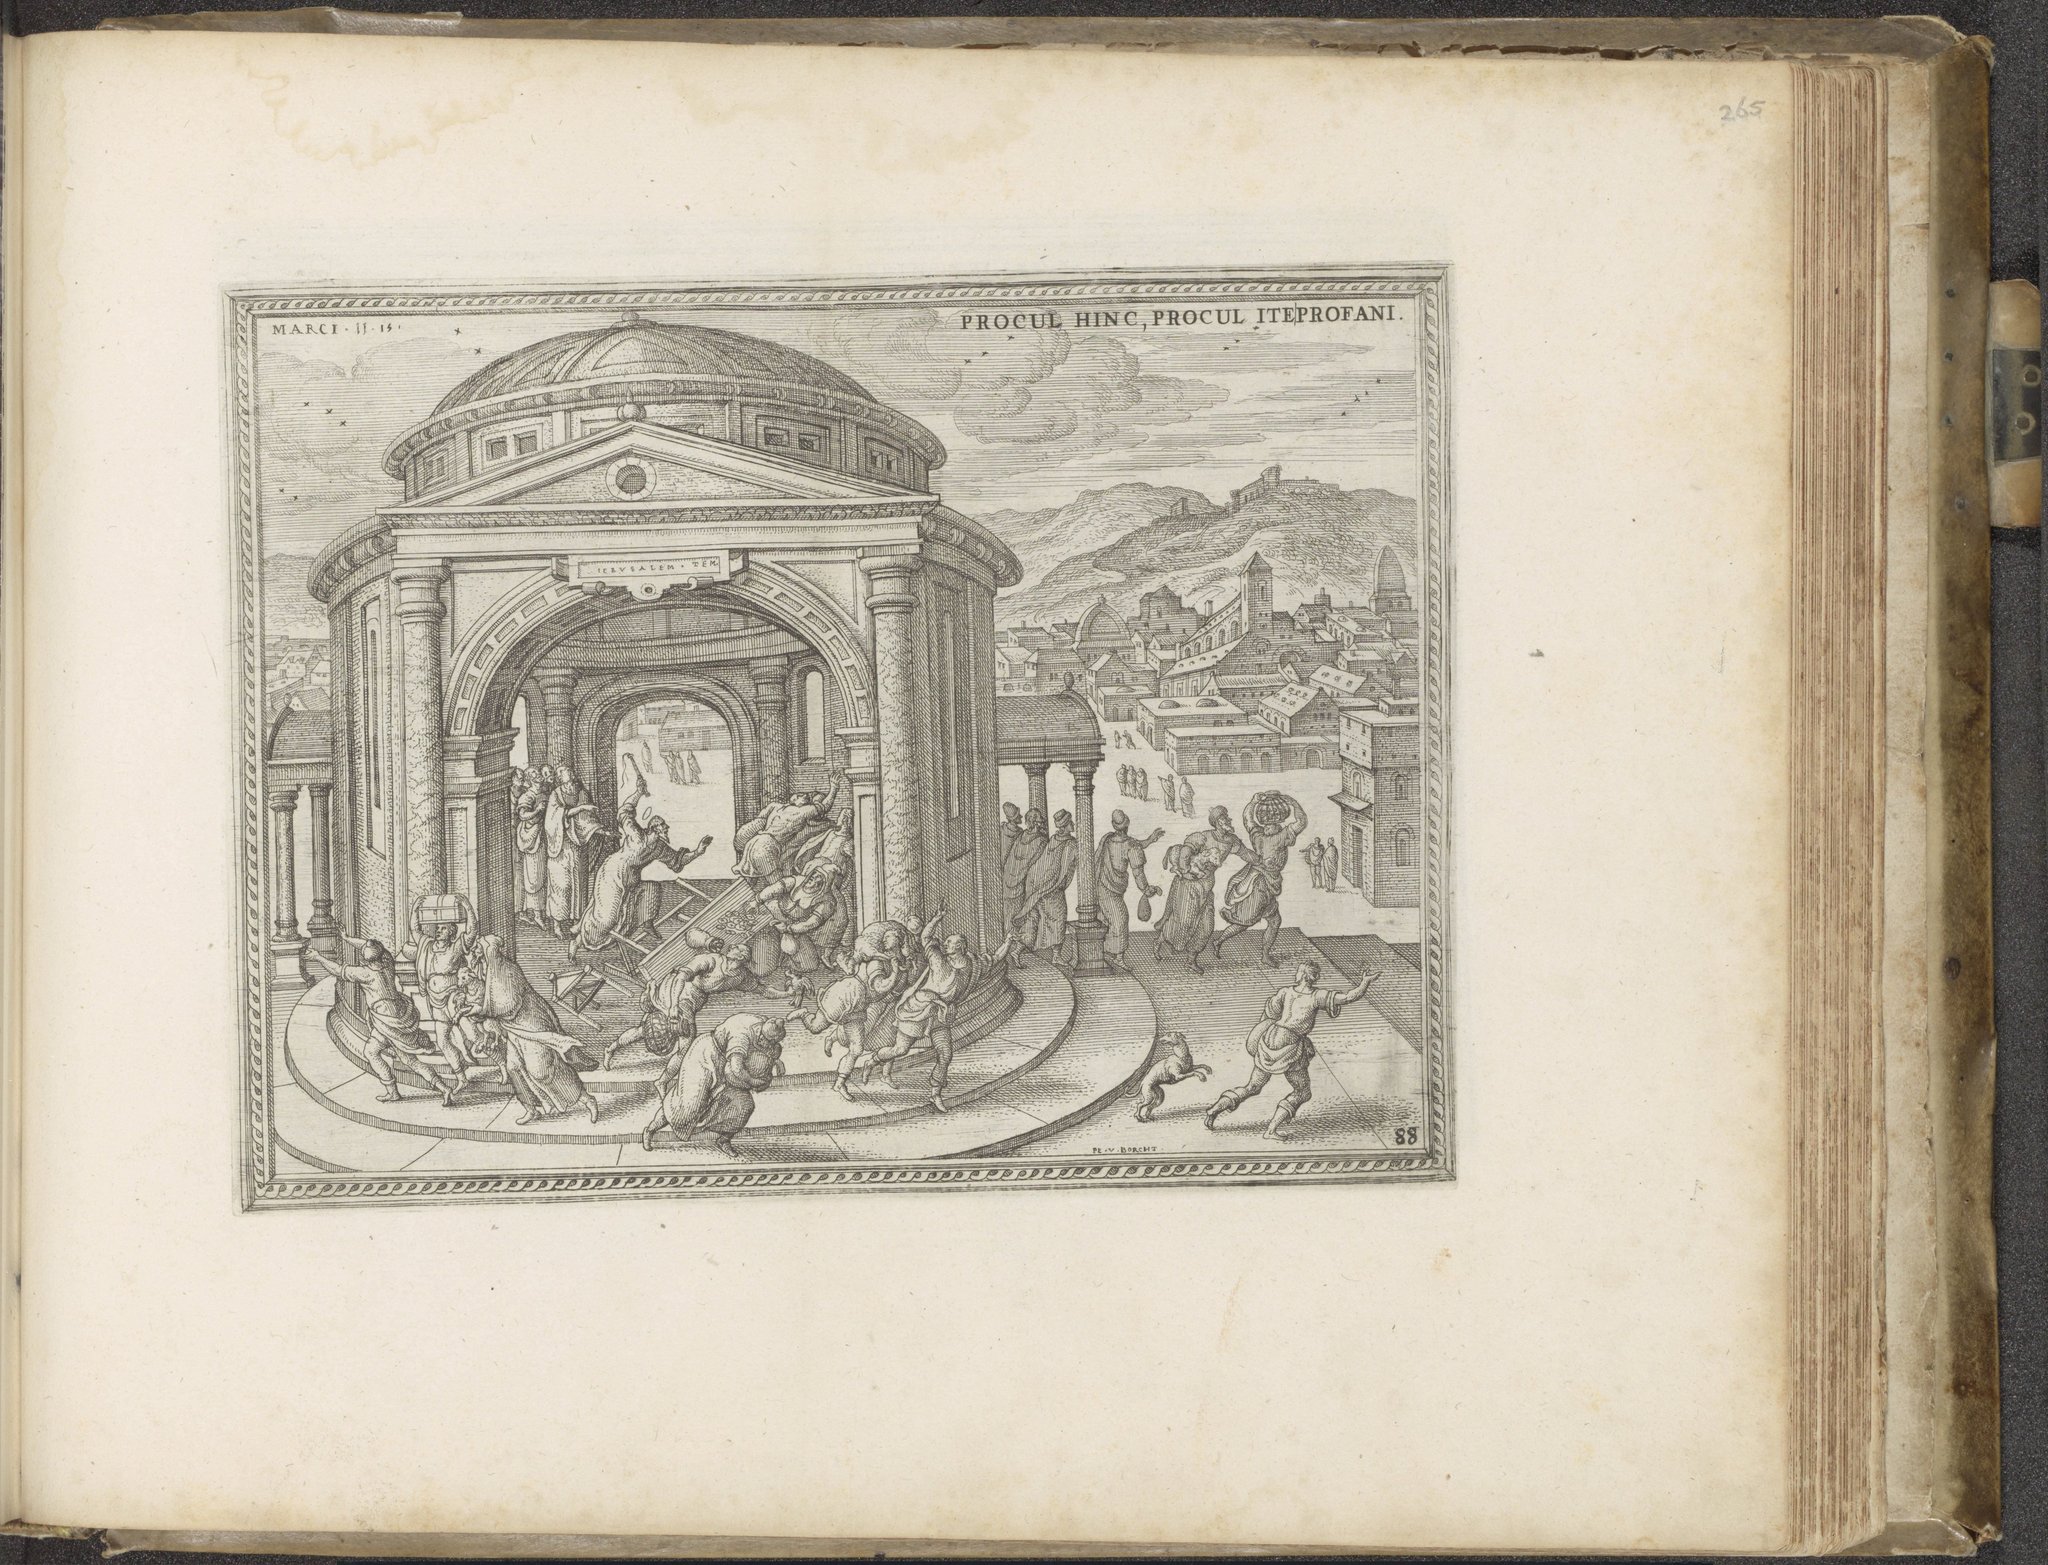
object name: album leaf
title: Procul hinc, procul ite profani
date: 1582-1593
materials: paper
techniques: etching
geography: amsterdam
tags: purification of the temple ('first' and 'second'): christ driving the money-changers from the temple with a whip (matthew 21:12-13; mark 11:15-17; luke 19:45-46; john 12:12-19)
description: Christus jaagt met een zweep de geldwisselaars uit de tempel. Hij gooit hun tafels omver. Een man probeert in zijn vlucht nog geld van de tafel te pakken. Anderen vluchten met een schaap of dragen een kooi met duiven (Mar. 11:15). Rechtsonder het nummer dat de prent in een eerdere uitgave had: 88. De prent maakt deel uit van een album.